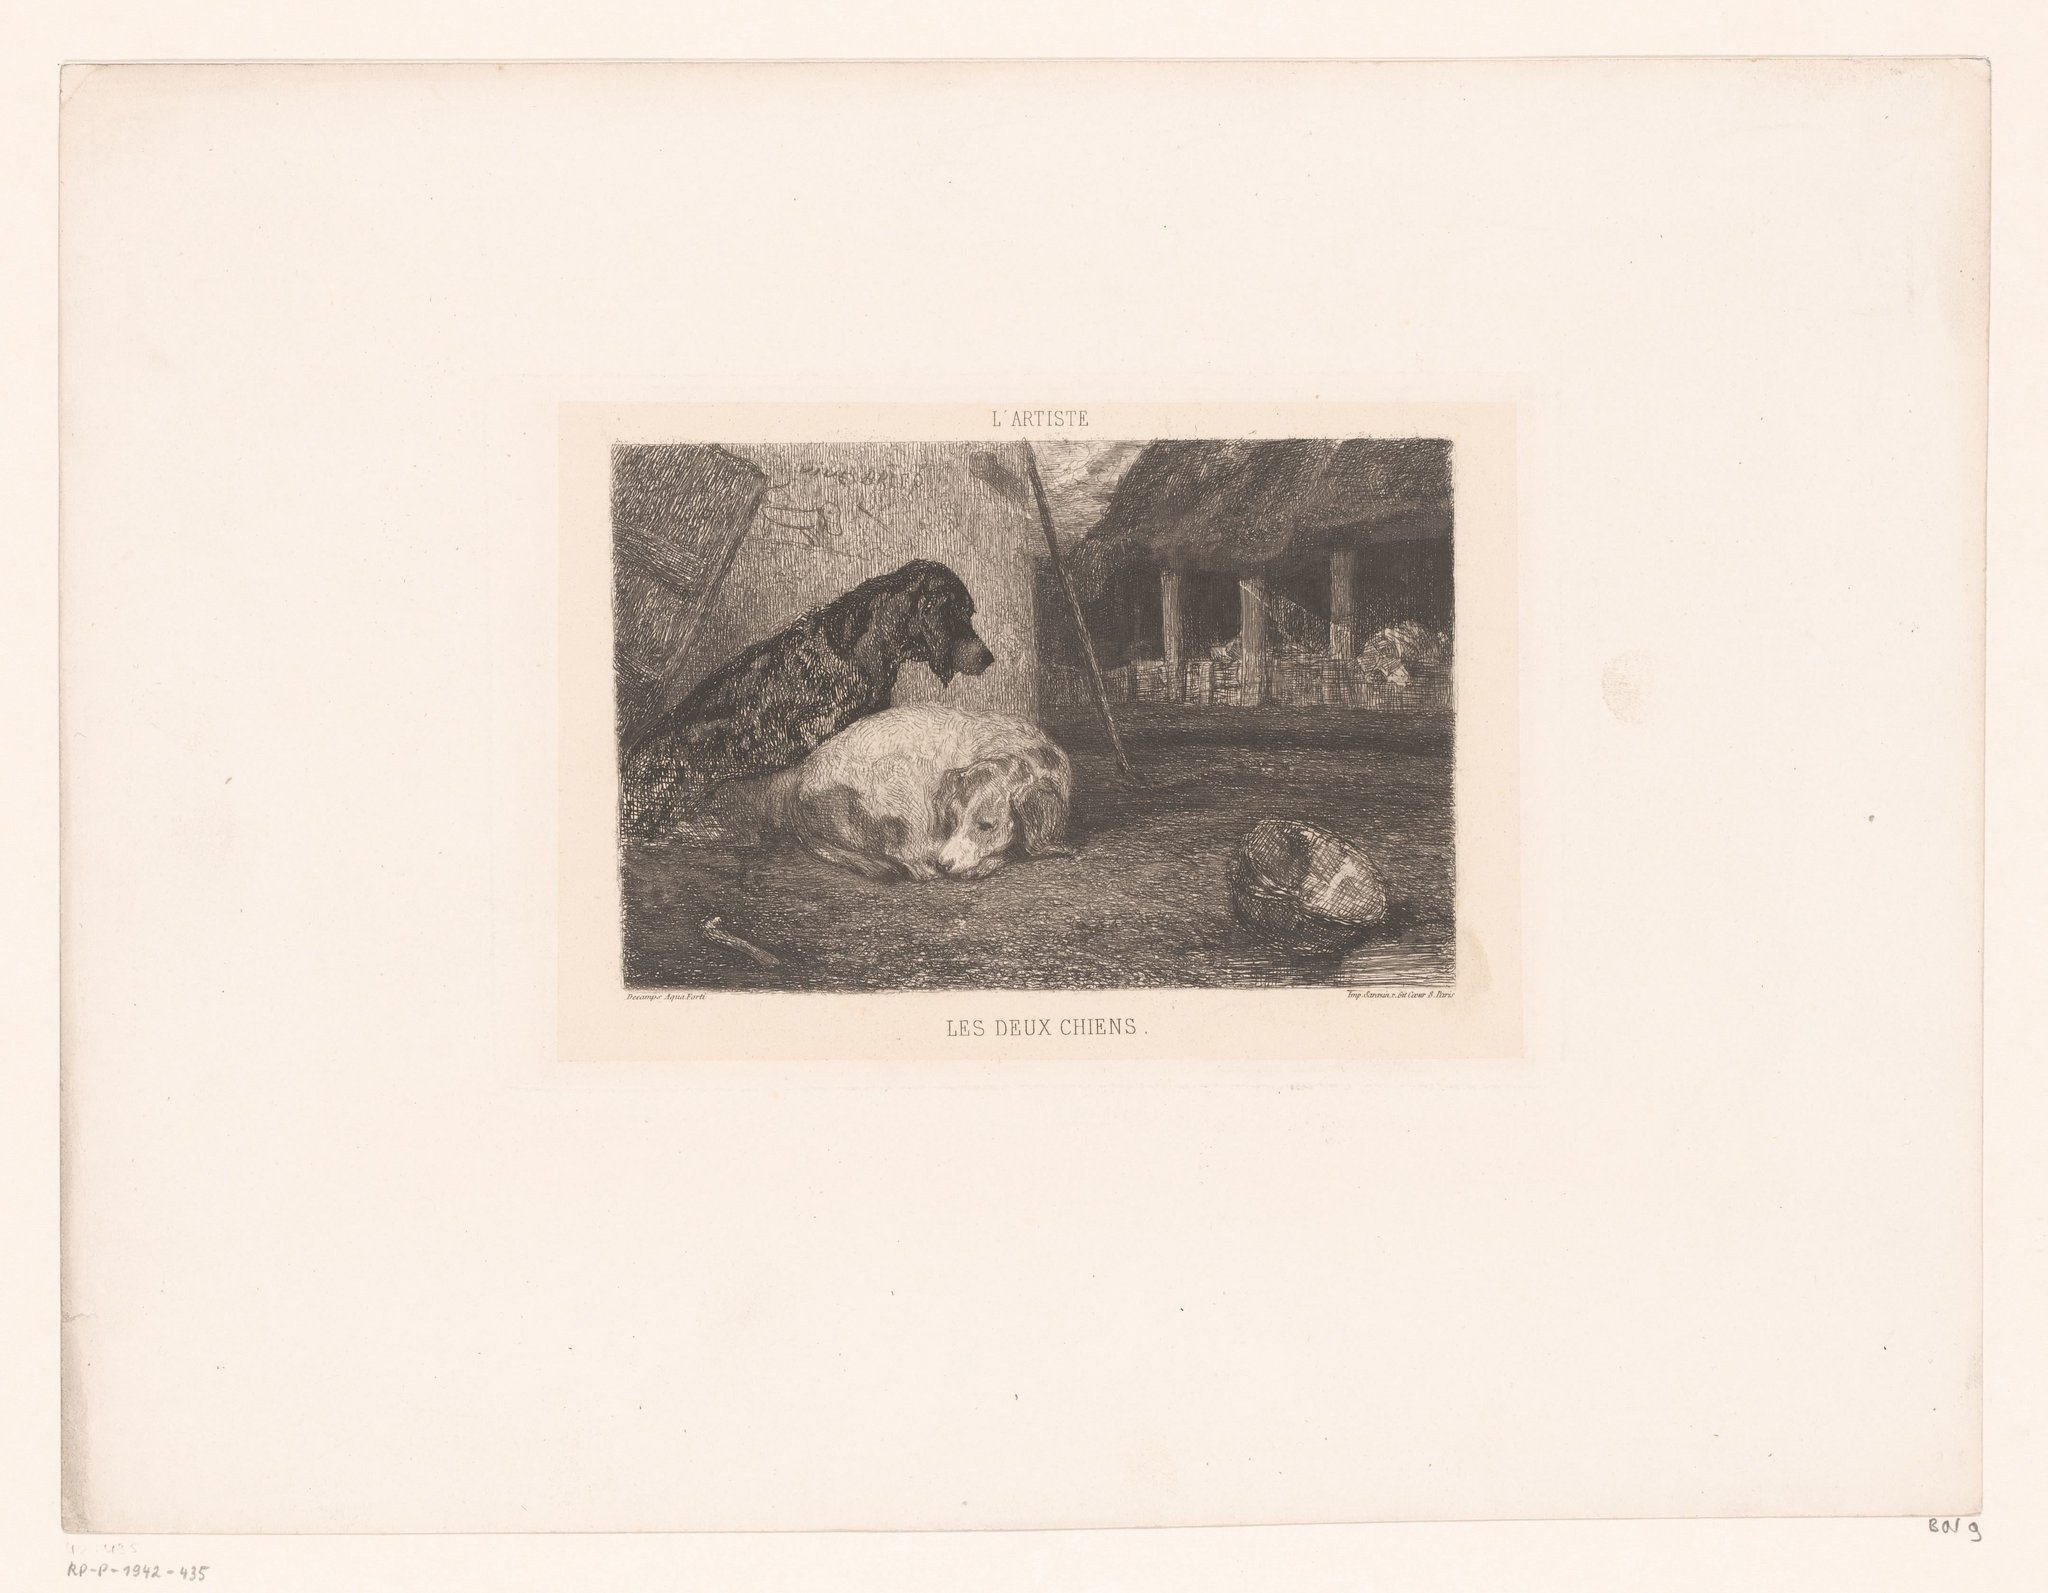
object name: print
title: L'artiste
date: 1858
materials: paper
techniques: drypoint, etching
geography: france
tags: courtyard, dog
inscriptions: collector's mark: Lugt 2760, collector's mark: Lugt 2228